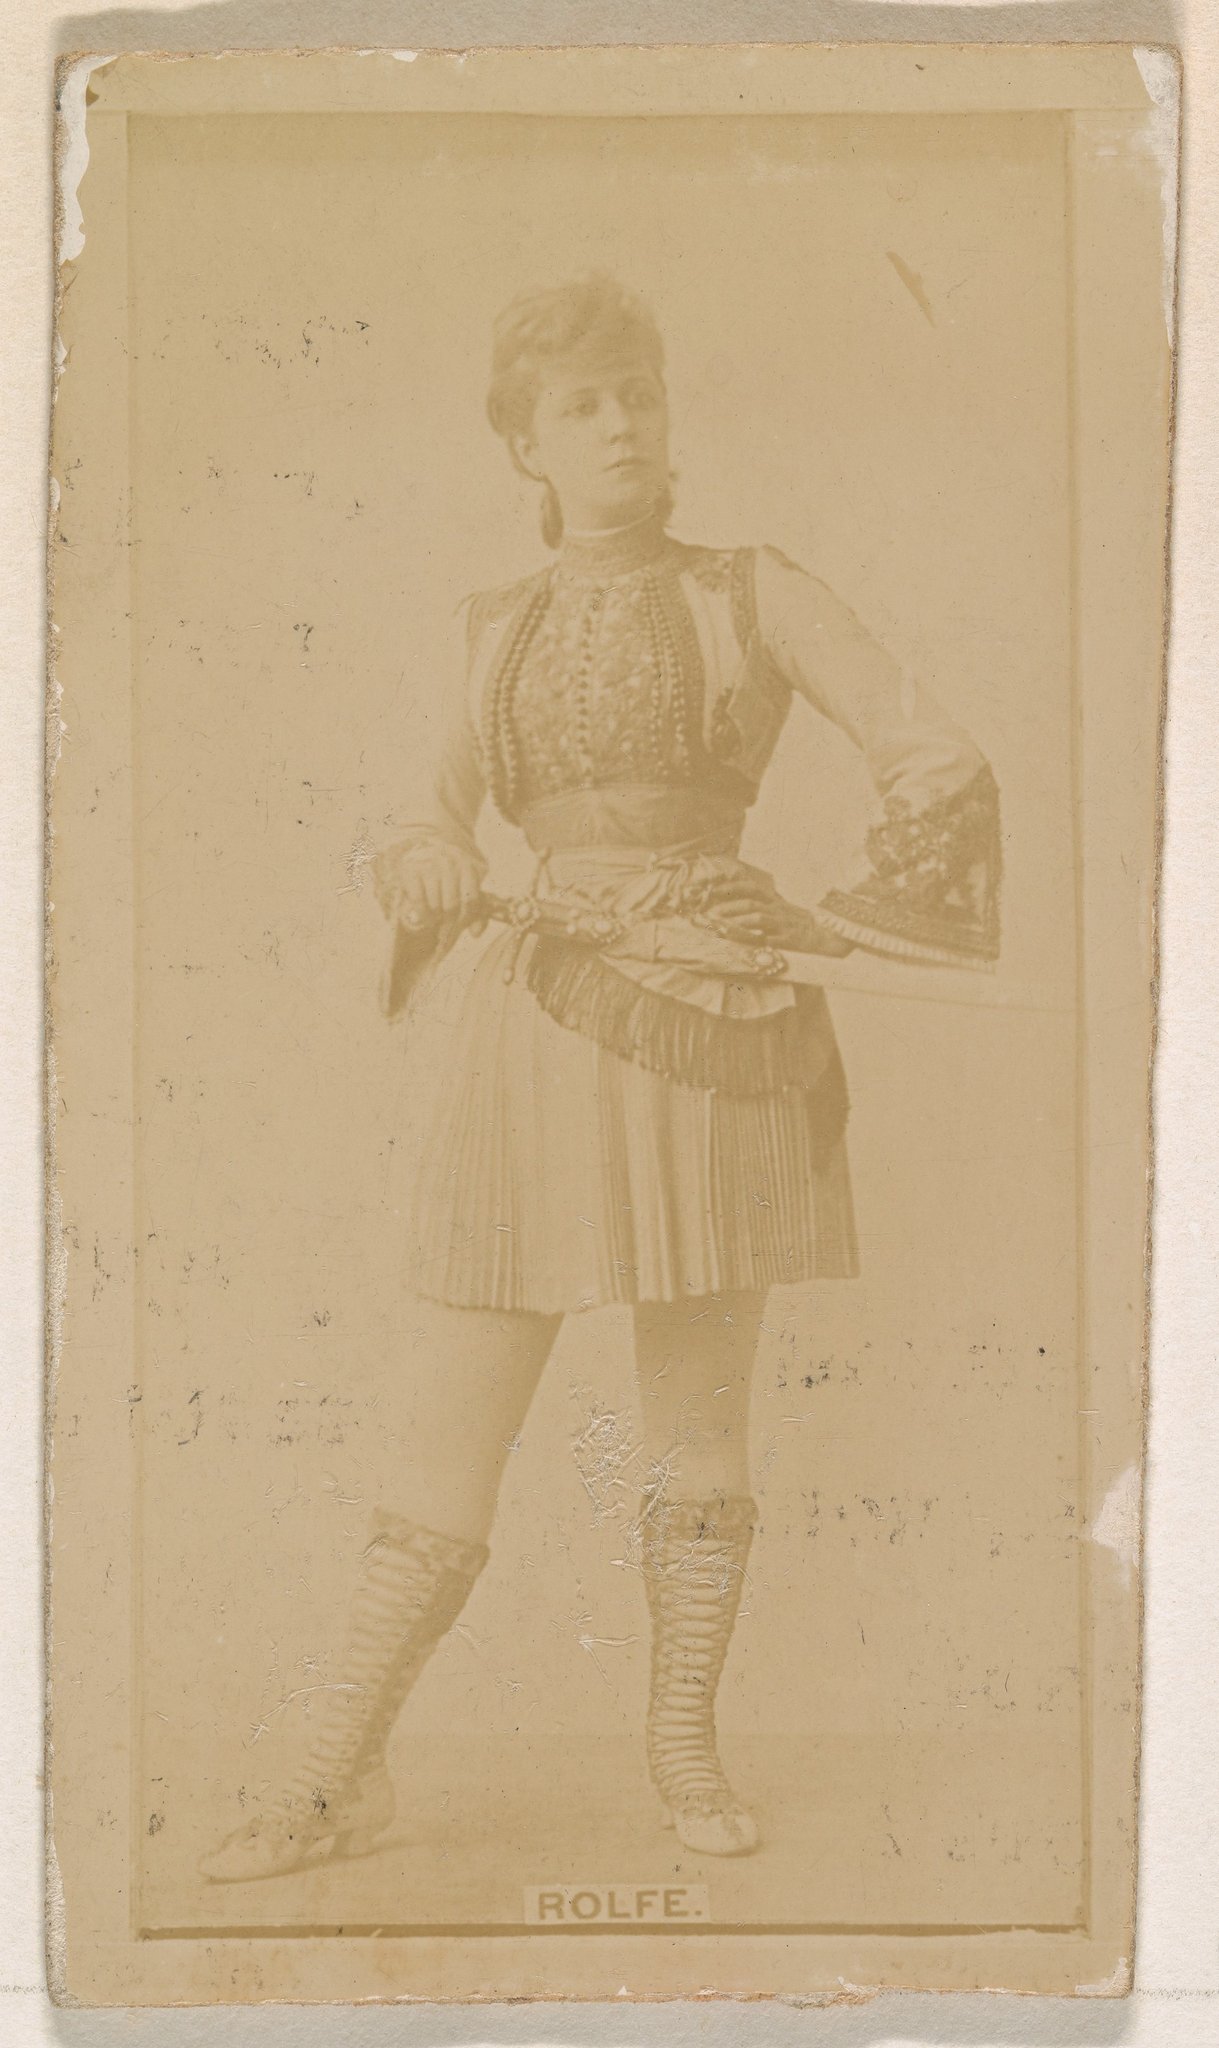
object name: photograph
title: Miss Rolfe, from the Actresses series (N245) issued by Kinney Brothers to promote Sweet Caporal Cigarettes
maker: kinney brothers tobacco company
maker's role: publisher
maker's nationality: american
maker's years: 1869-2011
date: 1890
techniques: albumen silver print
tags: portraits,women,actresses